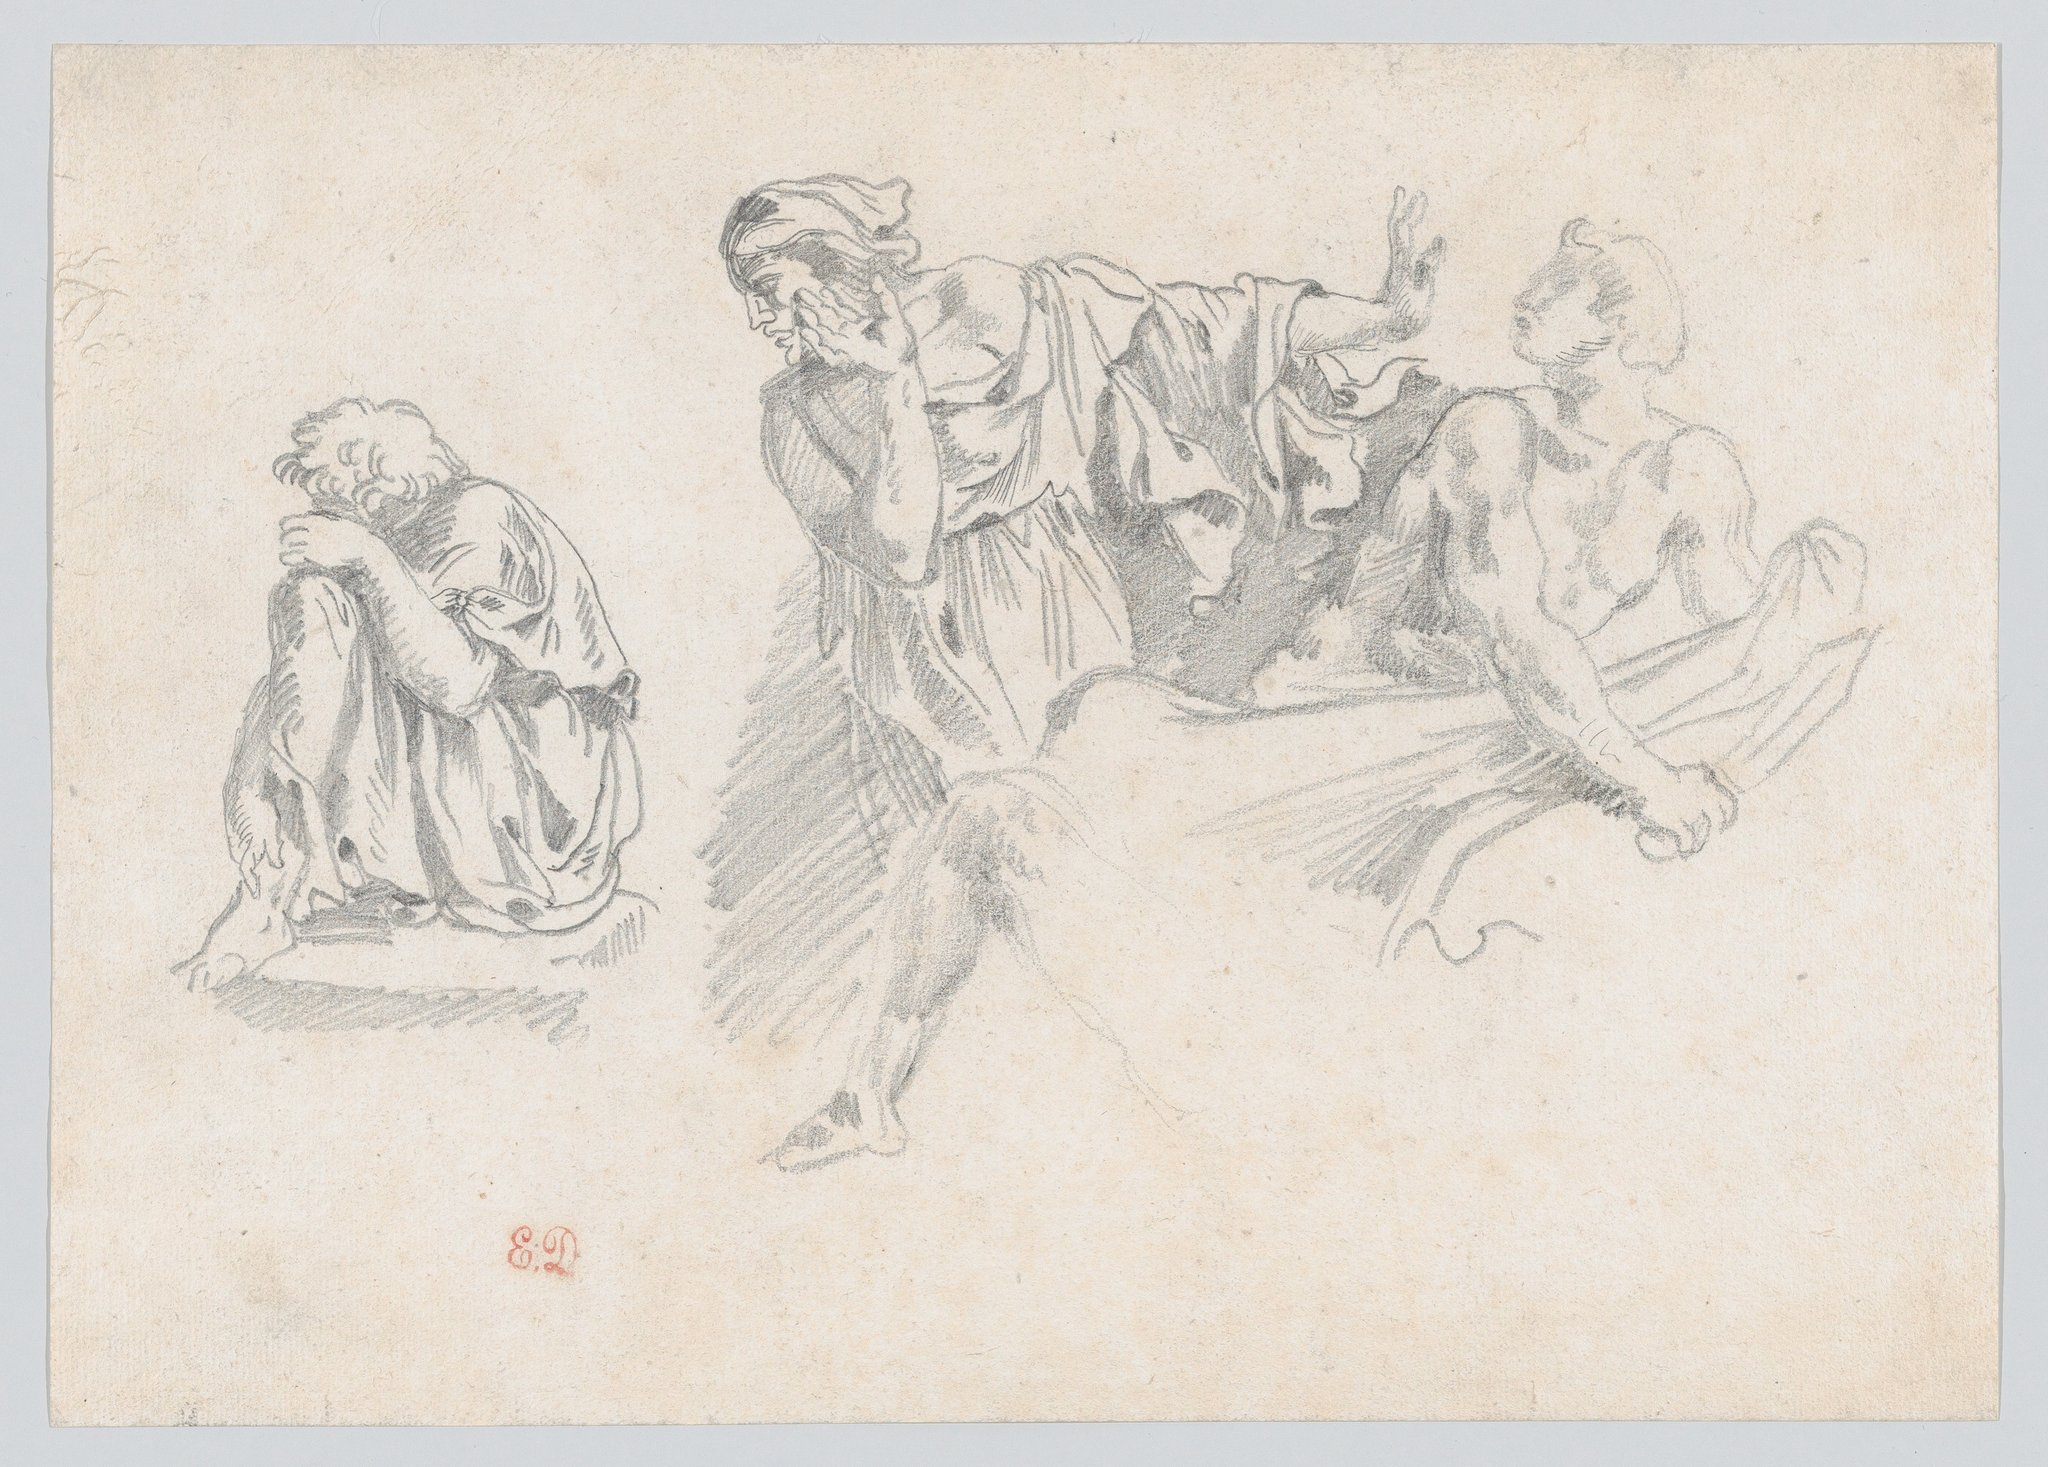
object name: drawing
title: Figures from an Antique Frieze, after Bartoli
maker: eugène delacroix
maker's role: artist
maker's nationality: french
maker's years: 1798-1863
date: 1822-1826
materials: graphite